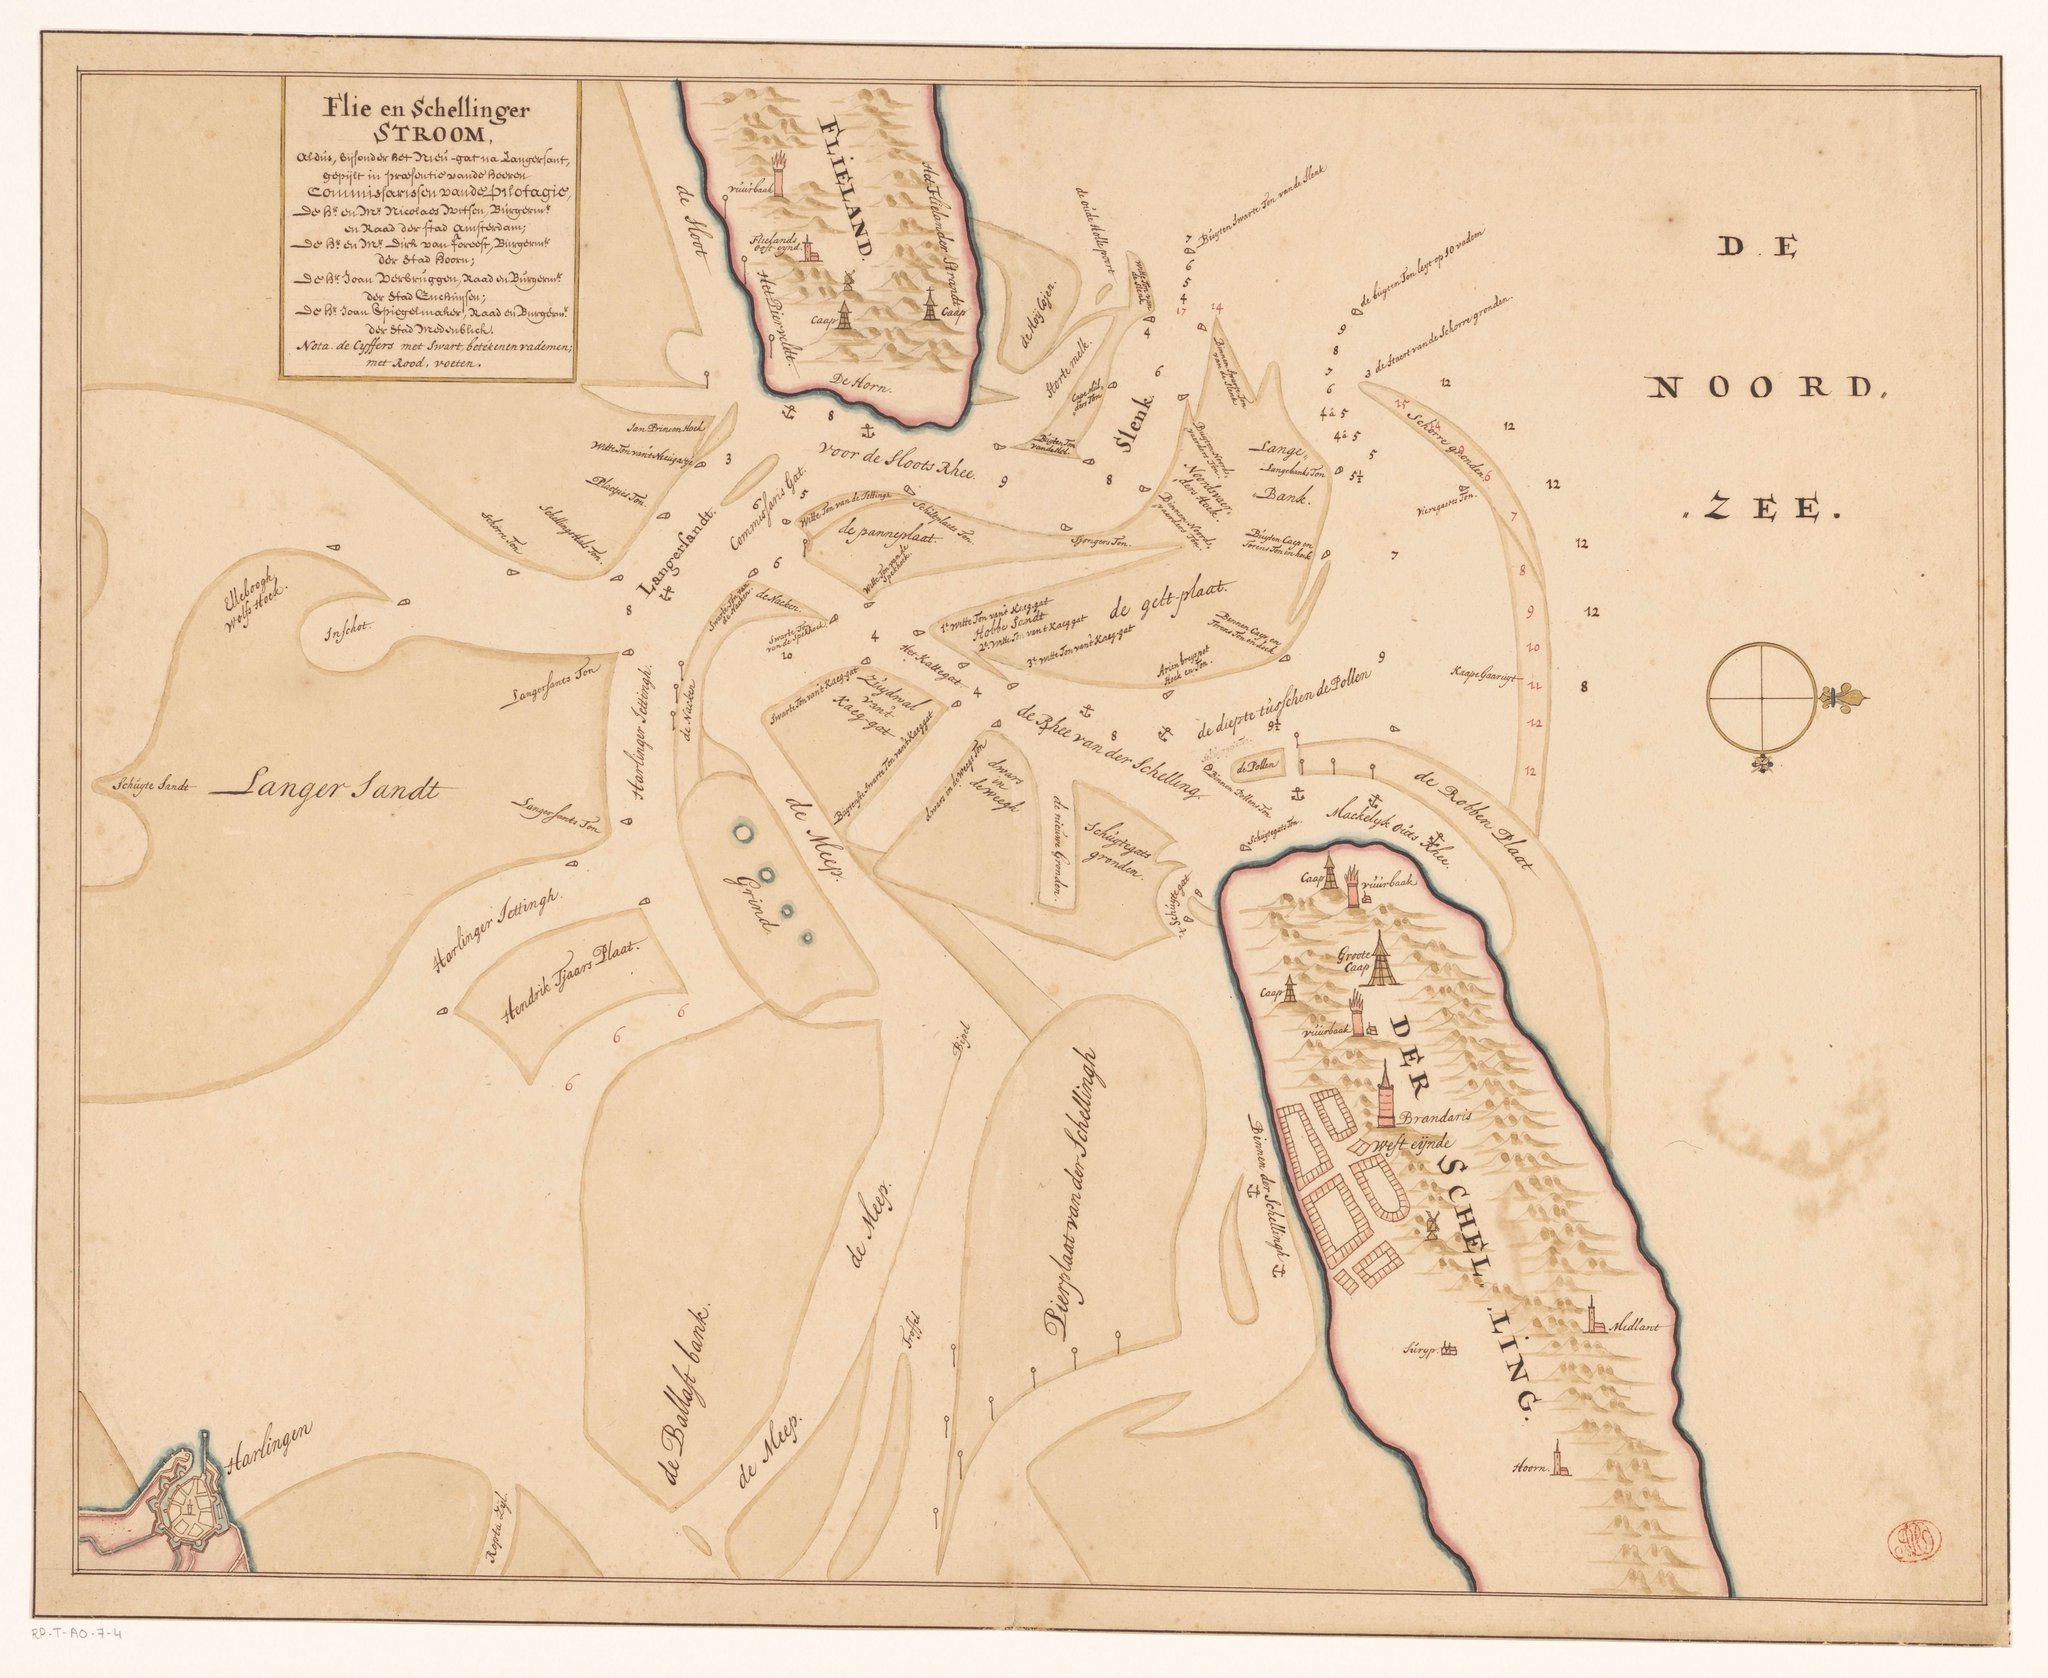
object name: drawing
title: Flie en Schellinger stroom, aldus, bijsonder het Nieu-gat na Langersant, gepijlt in praesentie vande heeren commissarissen vande Pilotagie, de hr. En mr. Nicolaes Witsen, burgermr. en raad der stad Amsterdam; de hr. en mr. Dirk van Foreest, burgermr. der stad Hoorn; de hr. Joan Verbruggen, raad en burgermr. der stad Enckhuysen; de hr. Joan Spiegelmaker, raad en burgermr. der stad Medenblick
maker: isaac de graaf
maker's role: draughtsman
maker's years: 1667-1743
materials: ink, paper, watercolor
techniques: brush, pen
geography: amsterdam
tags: maps of separate countries or regions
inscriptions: collector's mark: Lugt 195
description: Linksboven de titel en een opmerking: 'Nota de cyffers met swart, betekenen vademen [vadem]; met rood, voeten'.